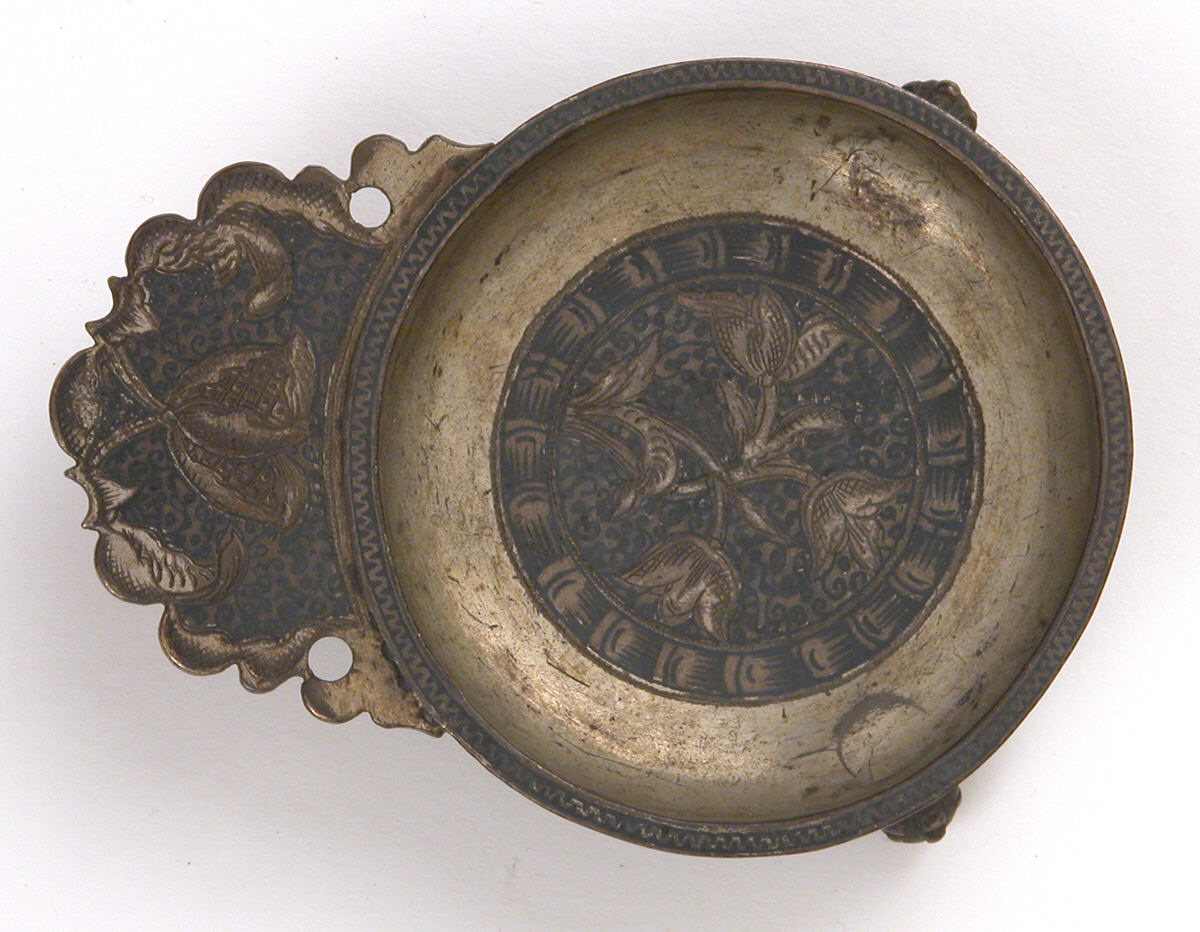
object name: tray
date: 1701-1800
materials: brass, niello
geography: central asia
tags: flowers